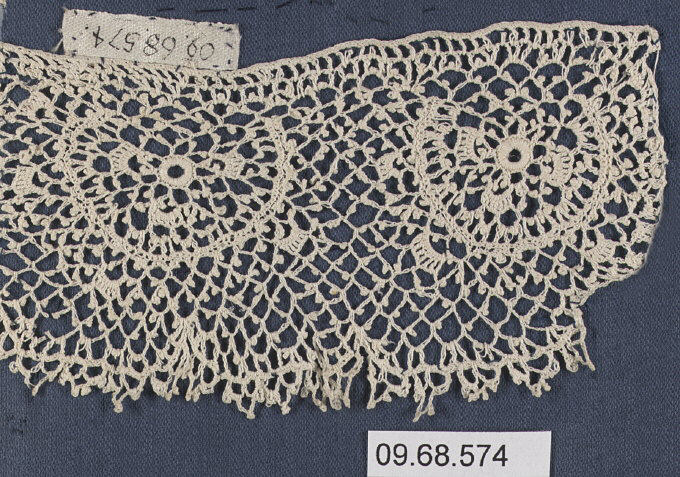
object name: specimen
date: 1801-1900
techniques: crochet